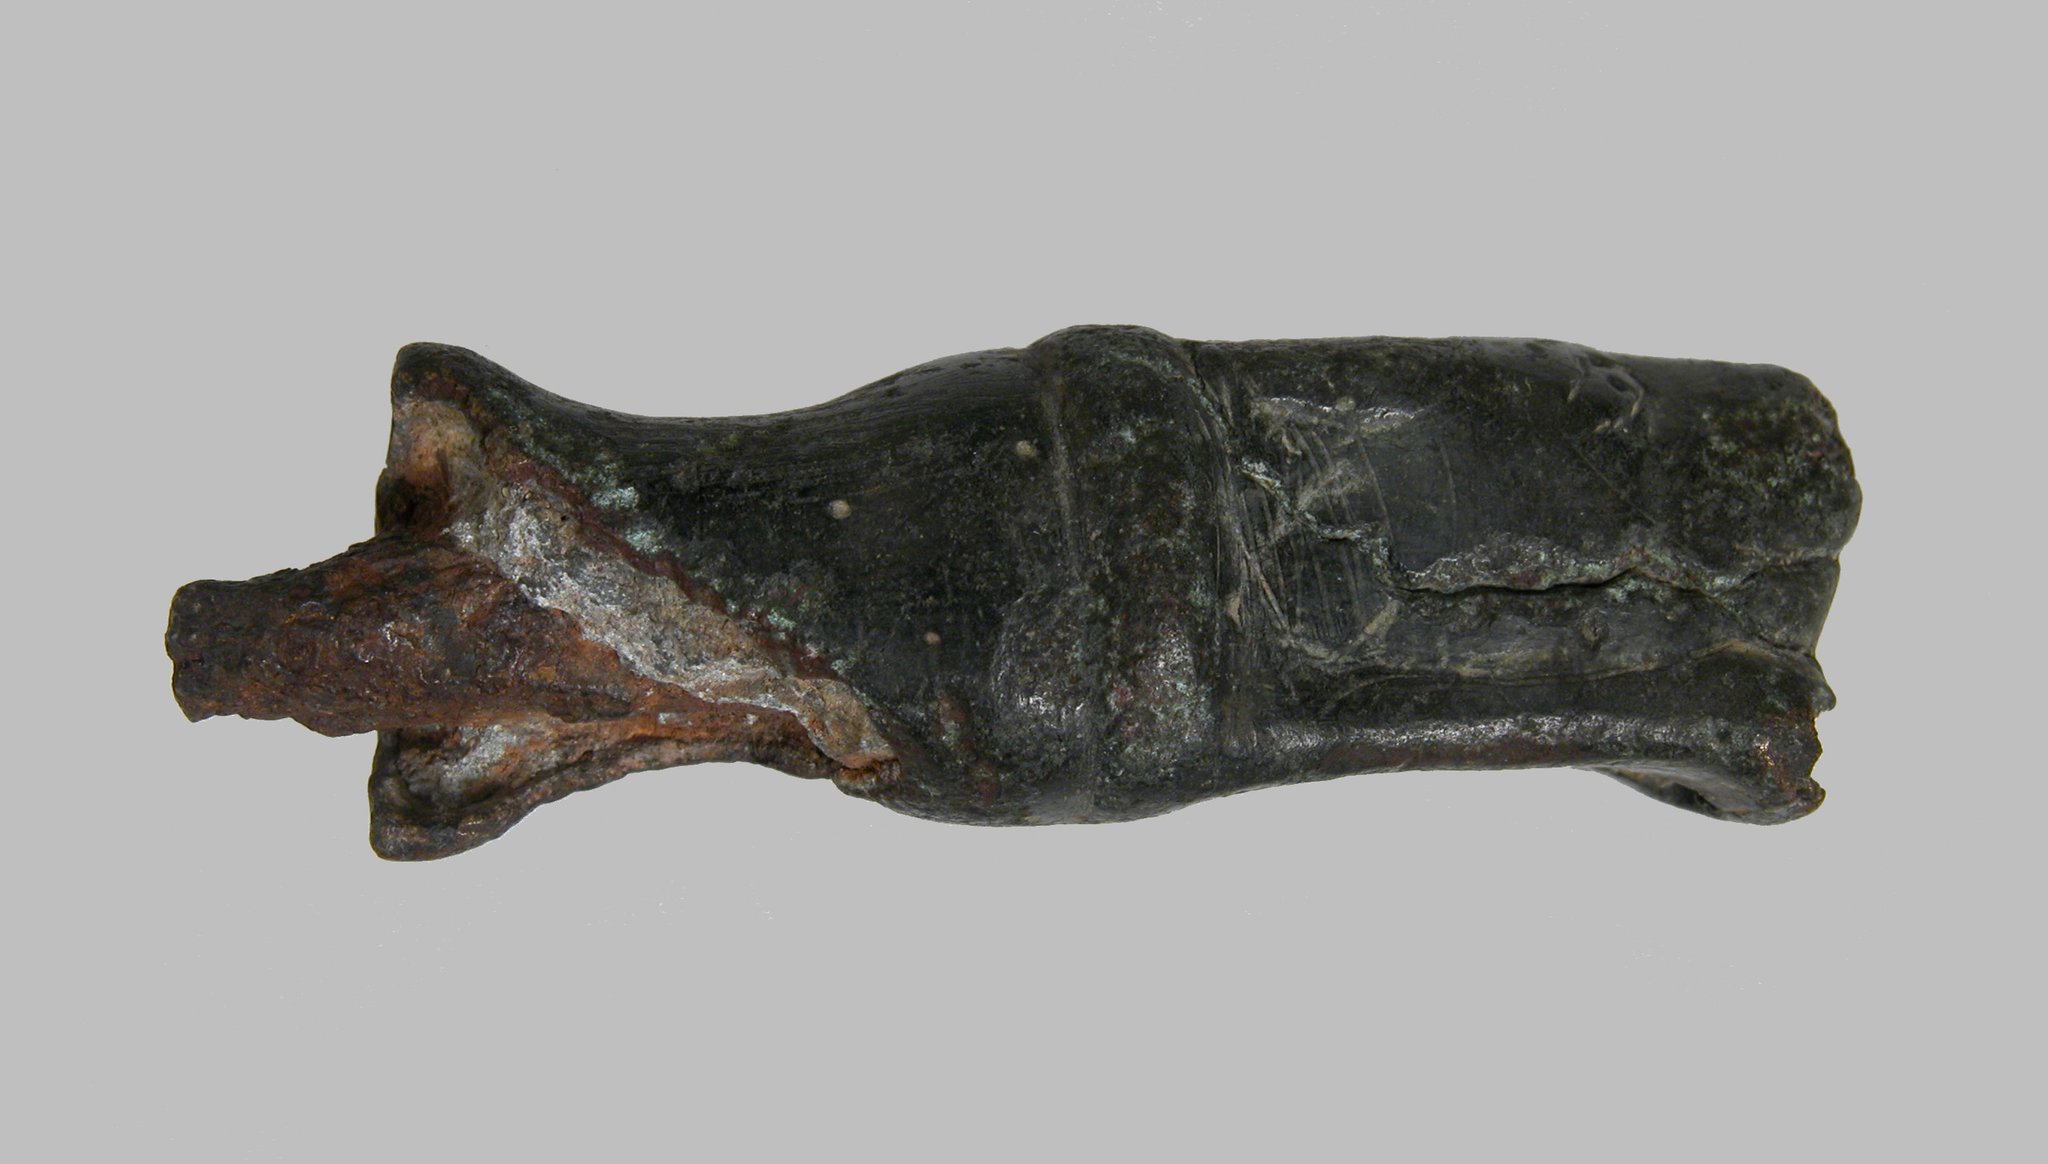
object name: key handle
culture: roman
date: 1-700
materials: copper alloy, iron